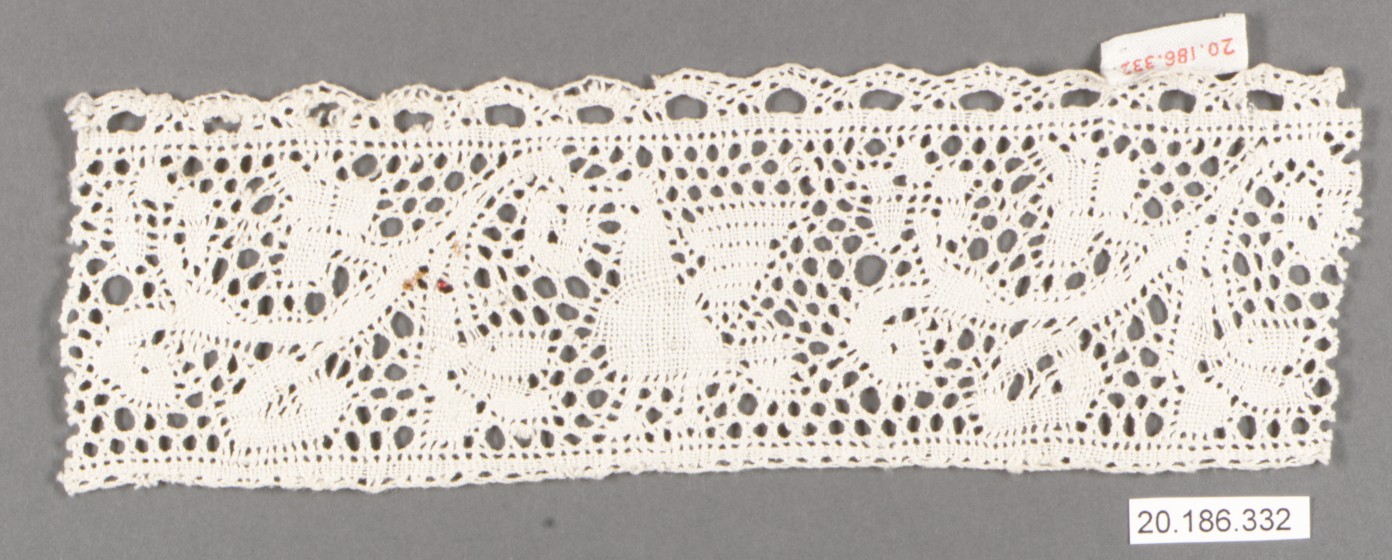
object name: edging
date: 1701-1800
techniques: lace